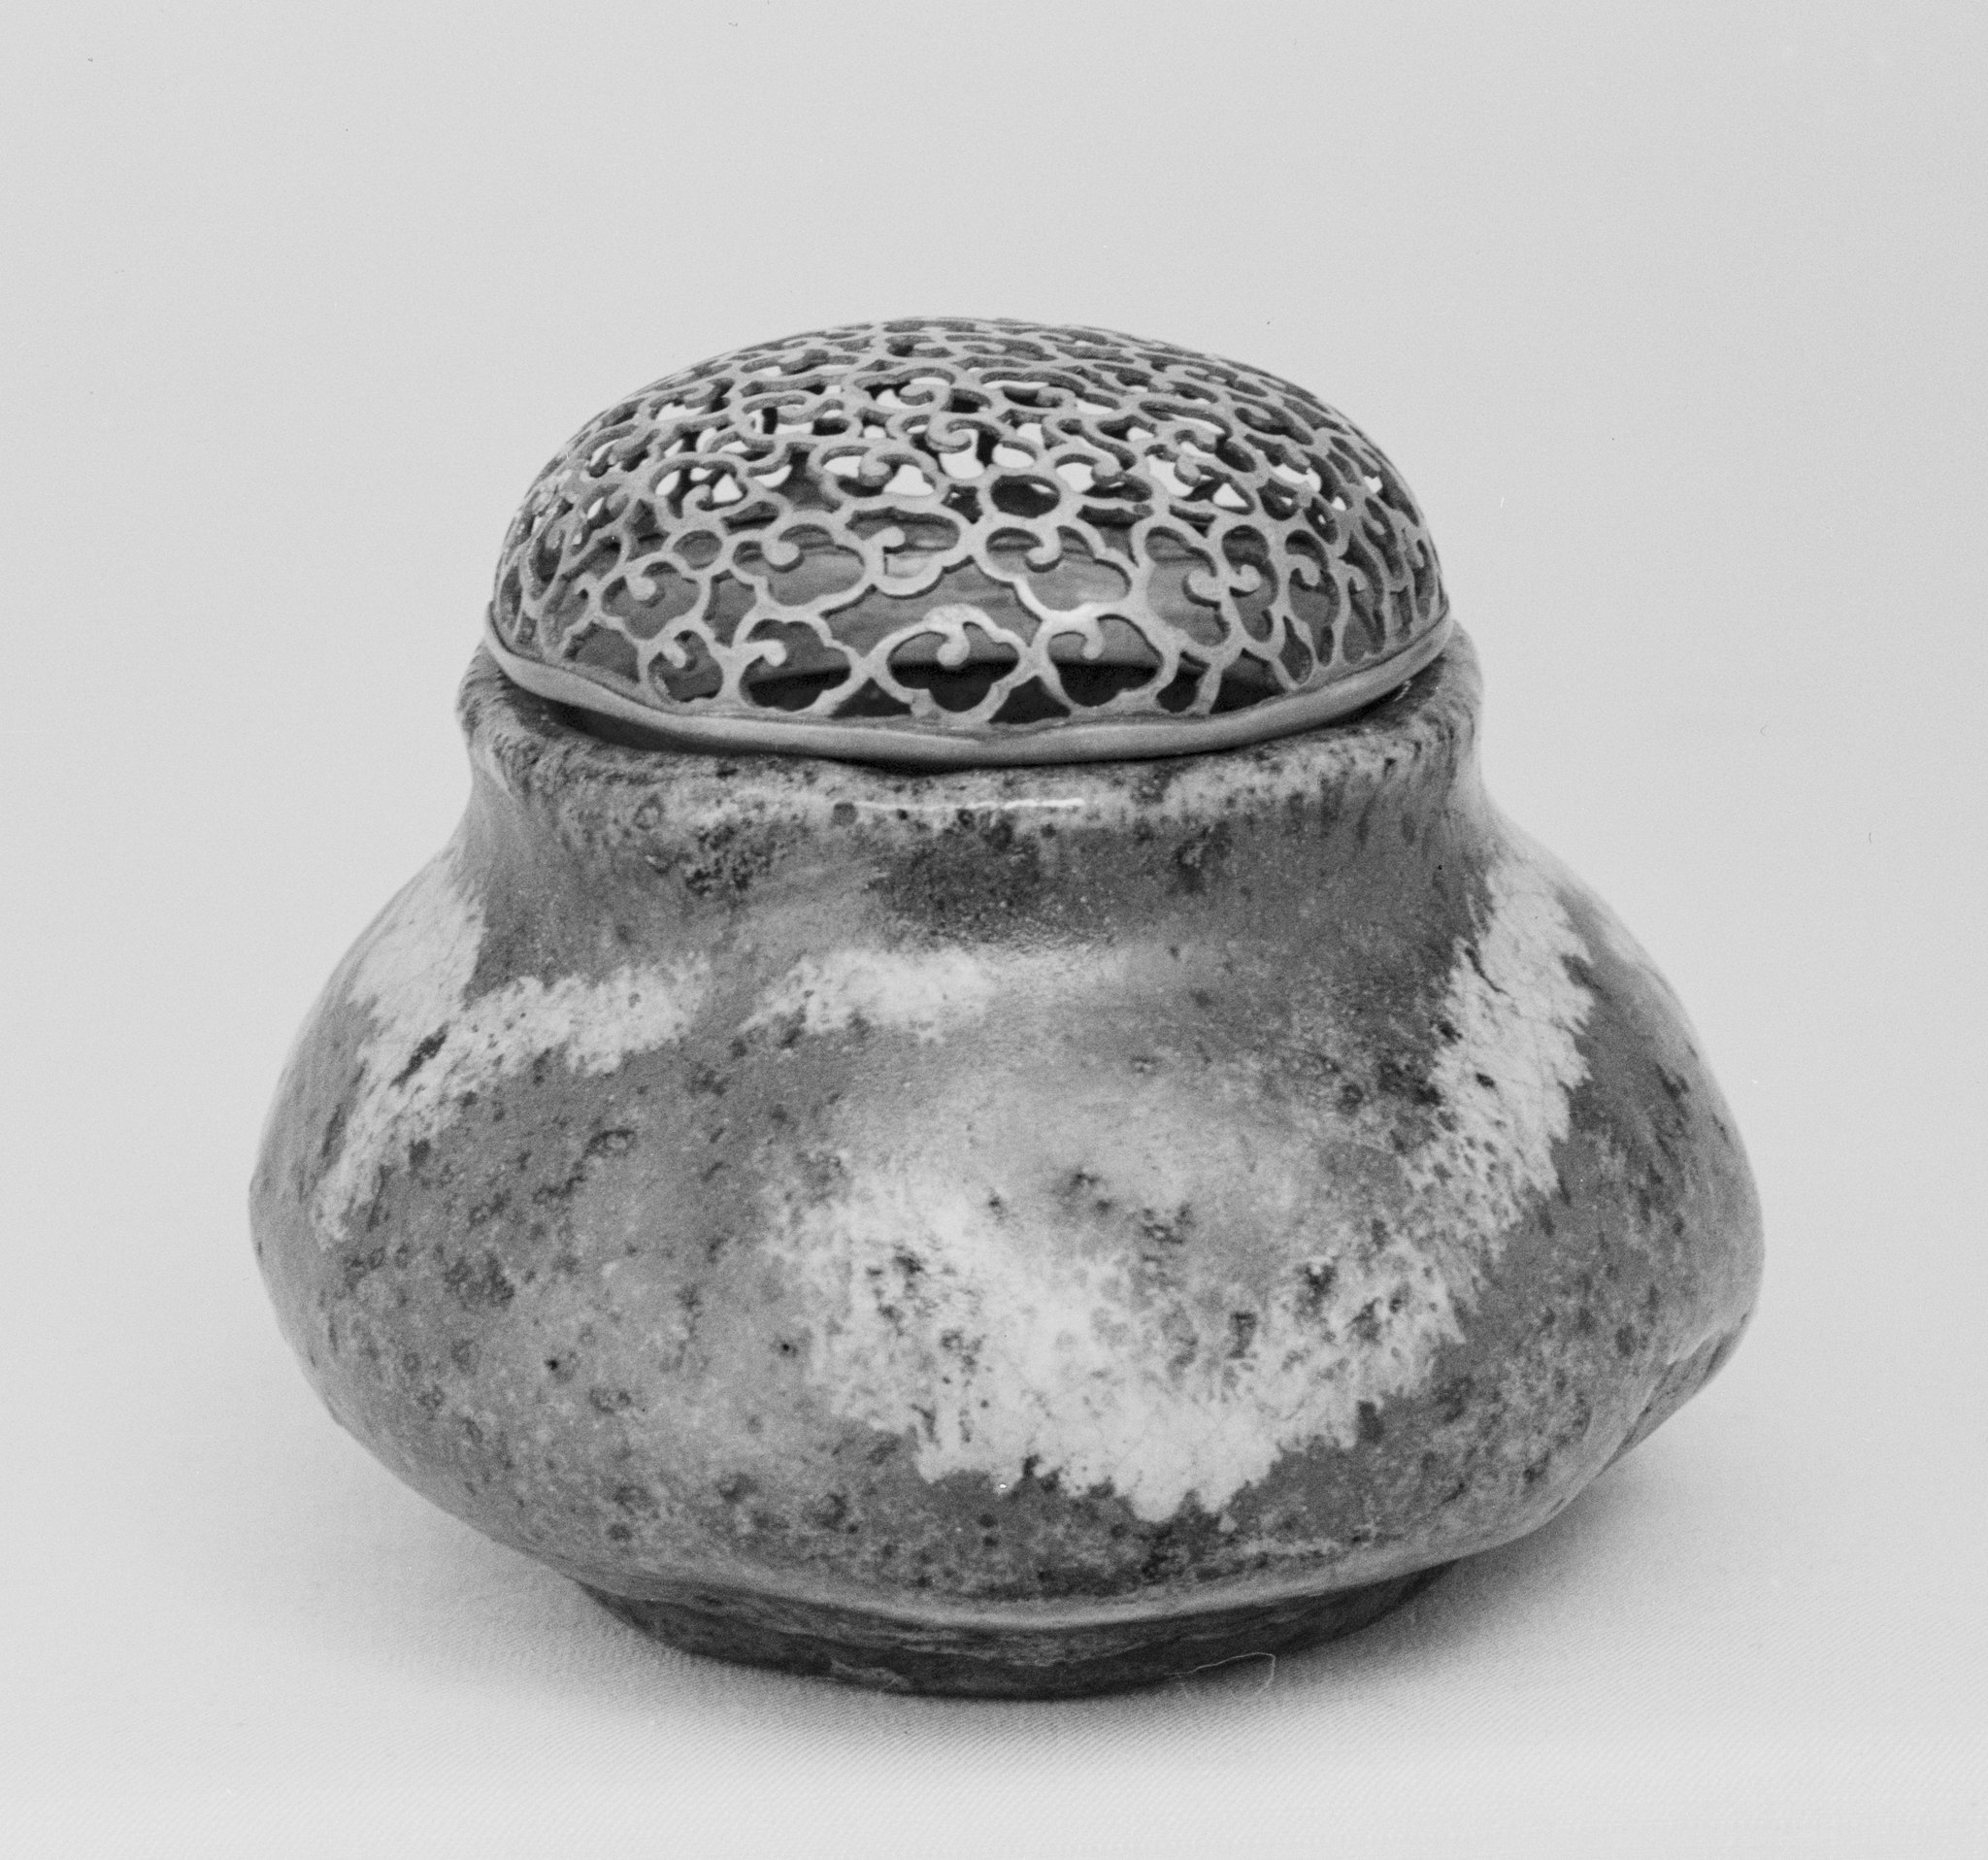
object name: covered incense burner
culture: japanese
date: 1701-1800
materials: clay, glaze